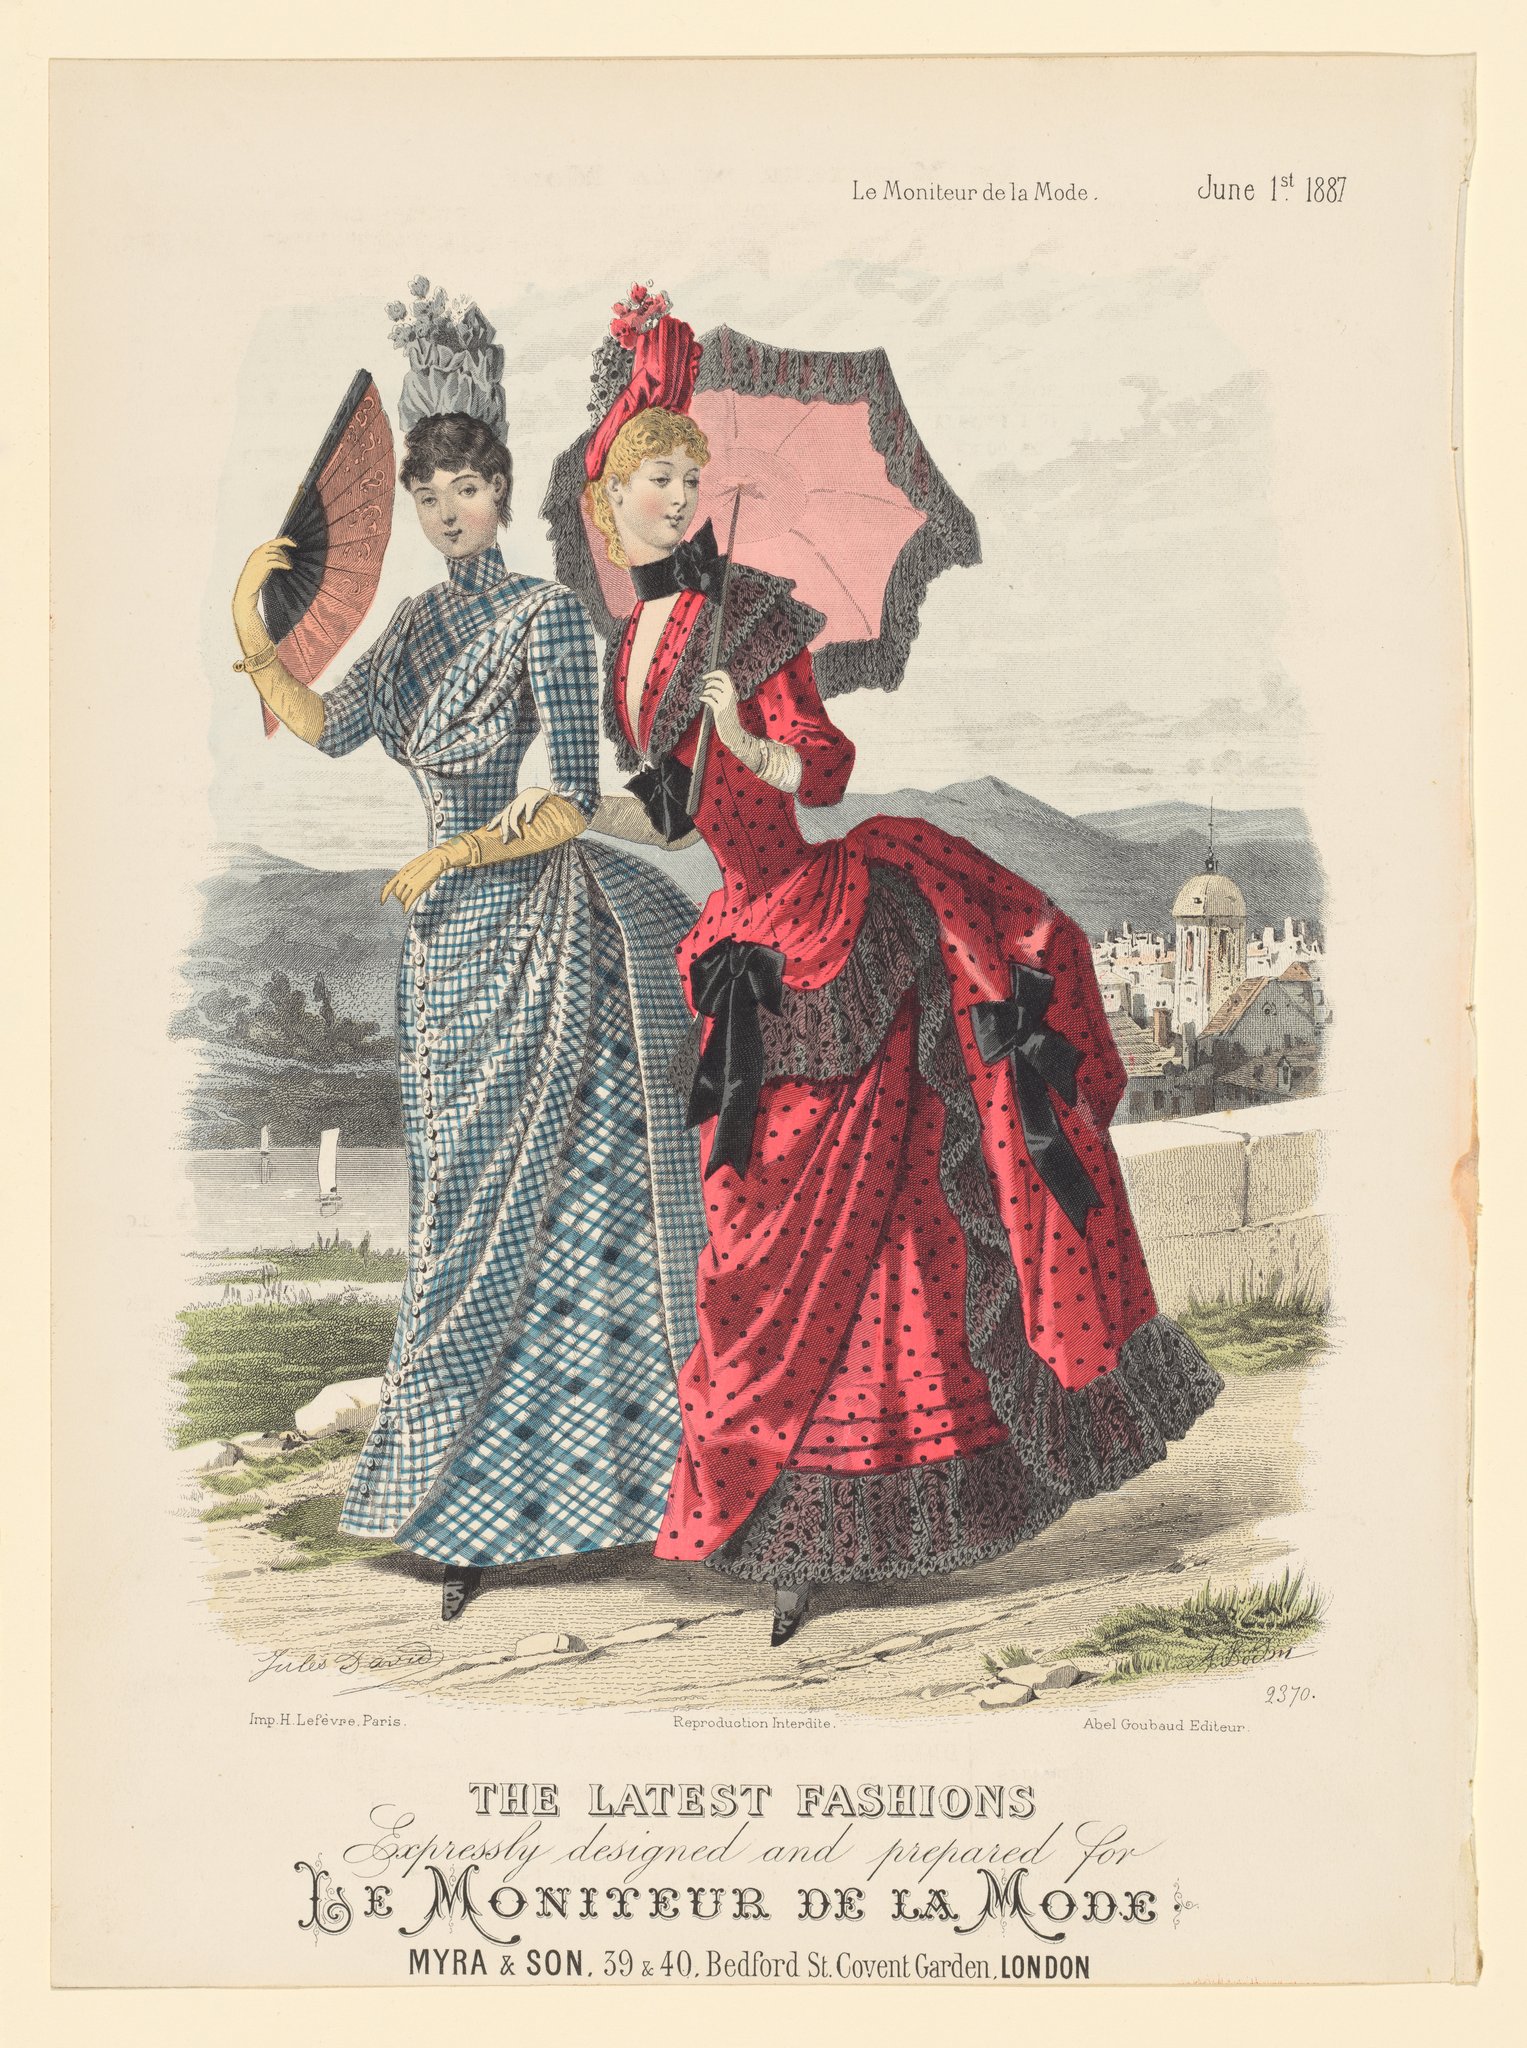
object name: print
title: The Latest Fashions, Expressly Designed and Prepared for Le Moniteur de la Mode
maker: a. bodin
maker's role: printmaker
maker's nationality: french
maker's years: 1800-1900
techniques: hand coloring, engraving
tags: women,fashion